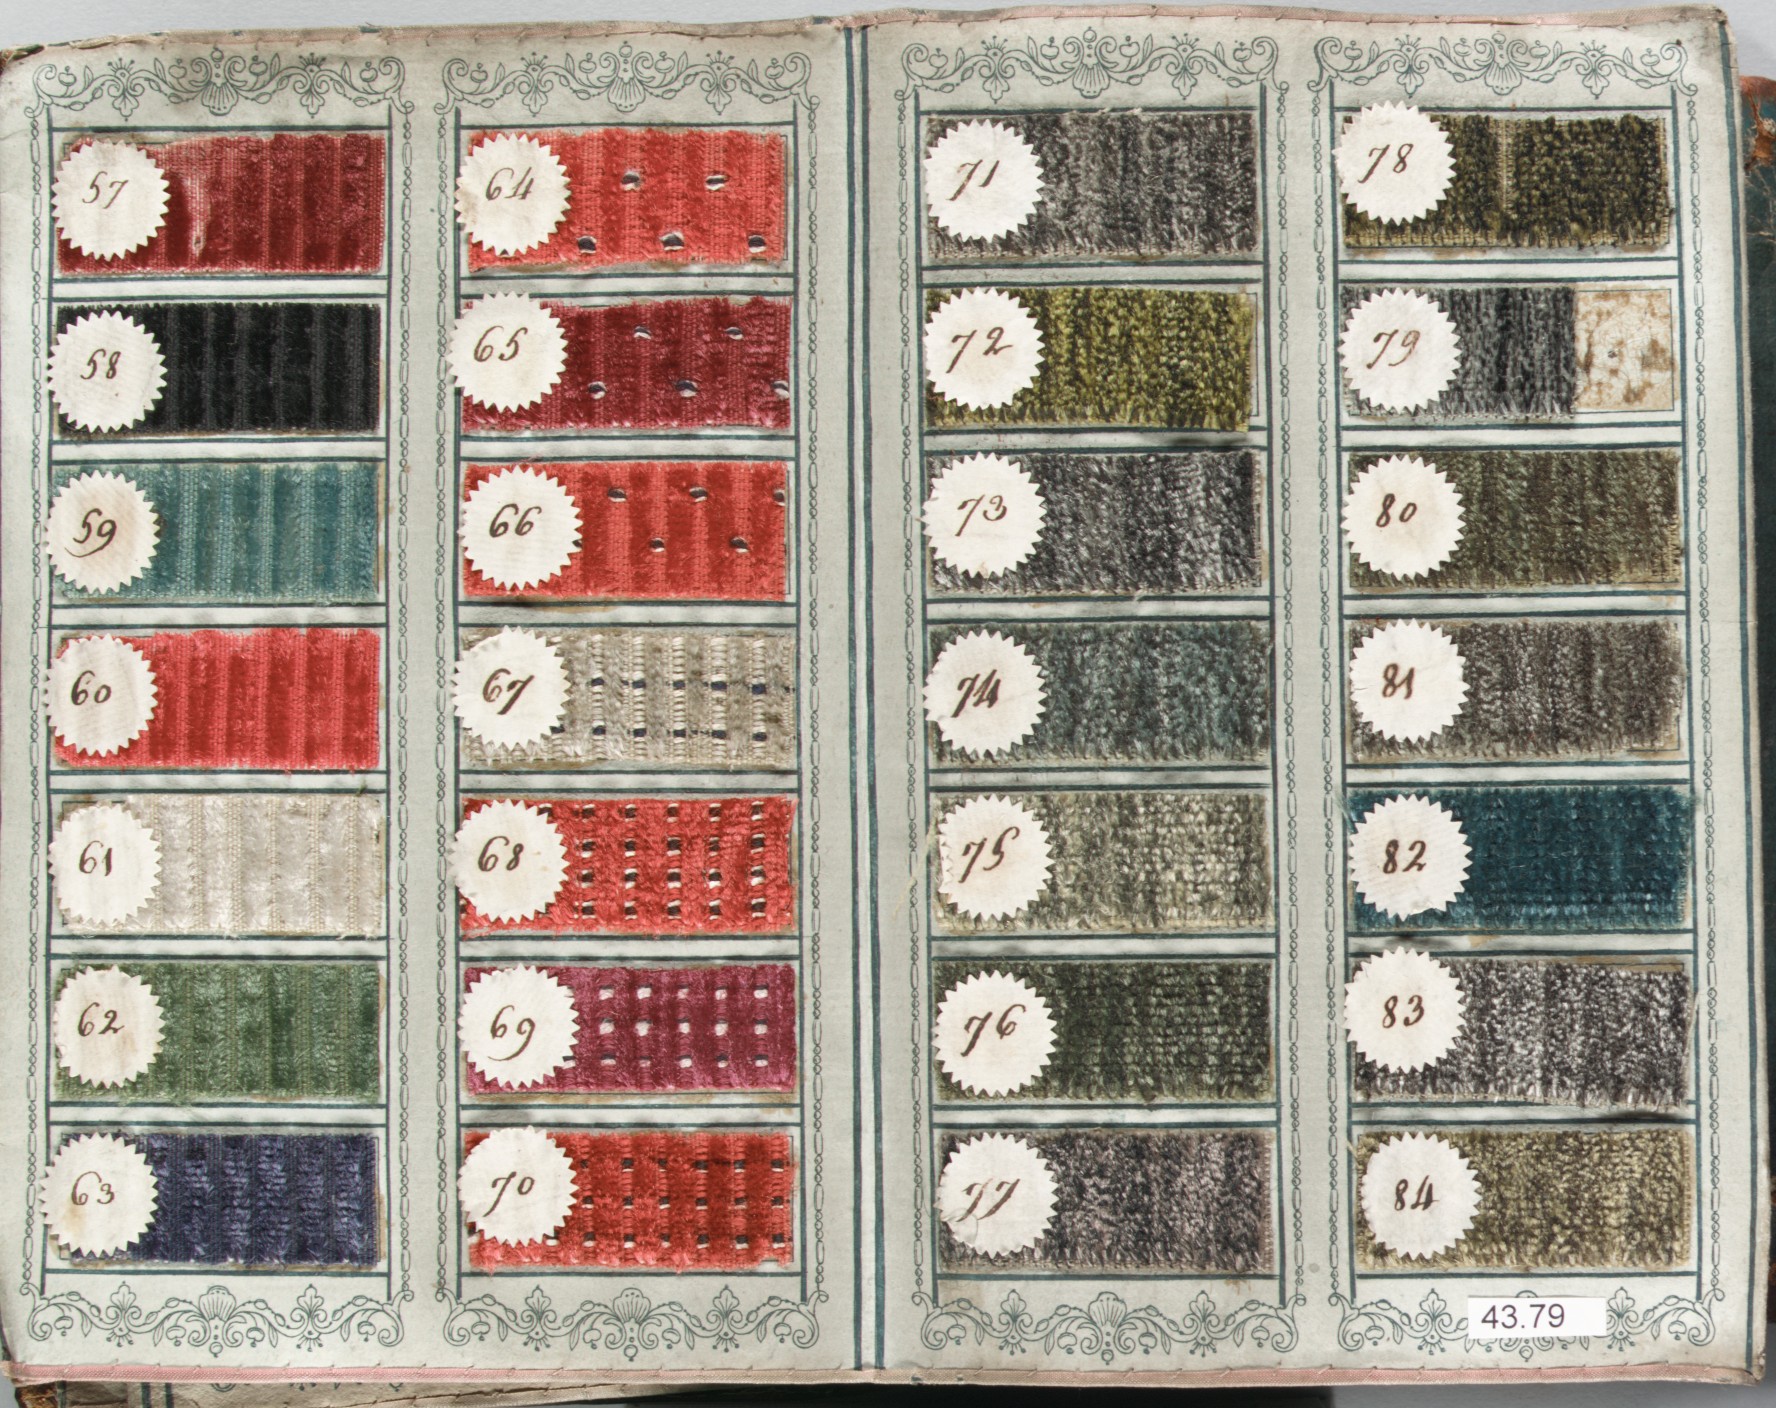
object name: sample book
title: Textile Sample Book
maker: françois debray et cie.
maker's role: manufactory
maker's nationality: french, amiens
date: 1767-1800